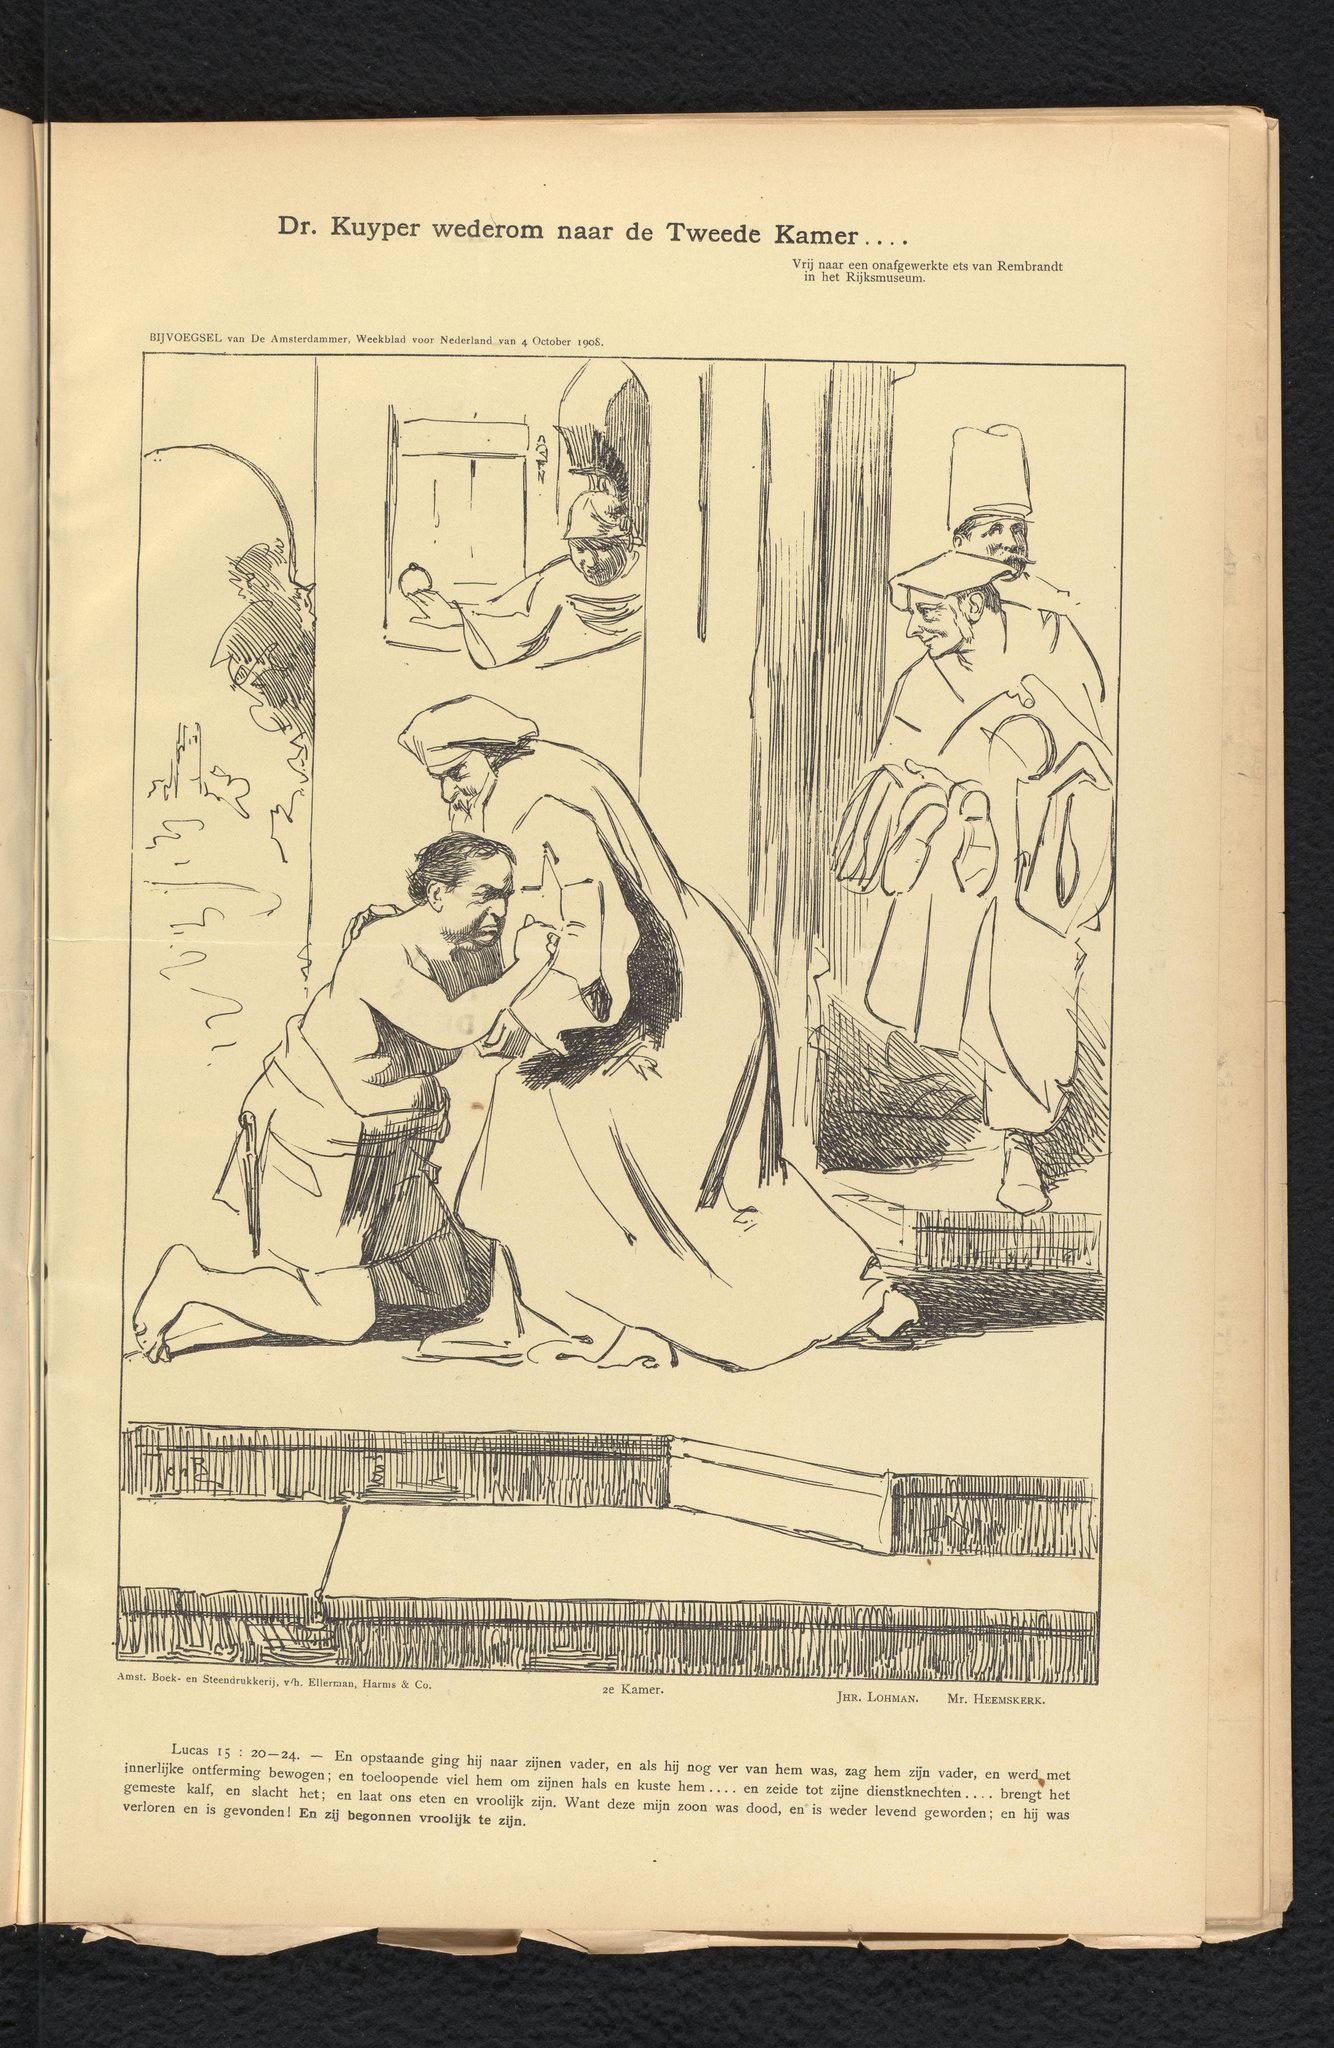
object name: cartoon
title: Dr. Kuyper wederom naar de Tweede Kamer ...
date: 1908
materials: paper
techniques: lithograph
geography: amsterdam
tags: the hague, jonkheer alexander frederik de savornin lohman, abraham kuyper, amsterdam, utrecht, the prodigal son kneels before his father who takes him in his arms, political caricatures and satires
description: Abraham Kuyper wordt als de teruggekeerde Verloren Zoon verwelkomd door de vader, de Tweede Kamer. Rechts de dienaren Lohman en Heemskerk met schone kleren. Naar de ets van Rembrandt.